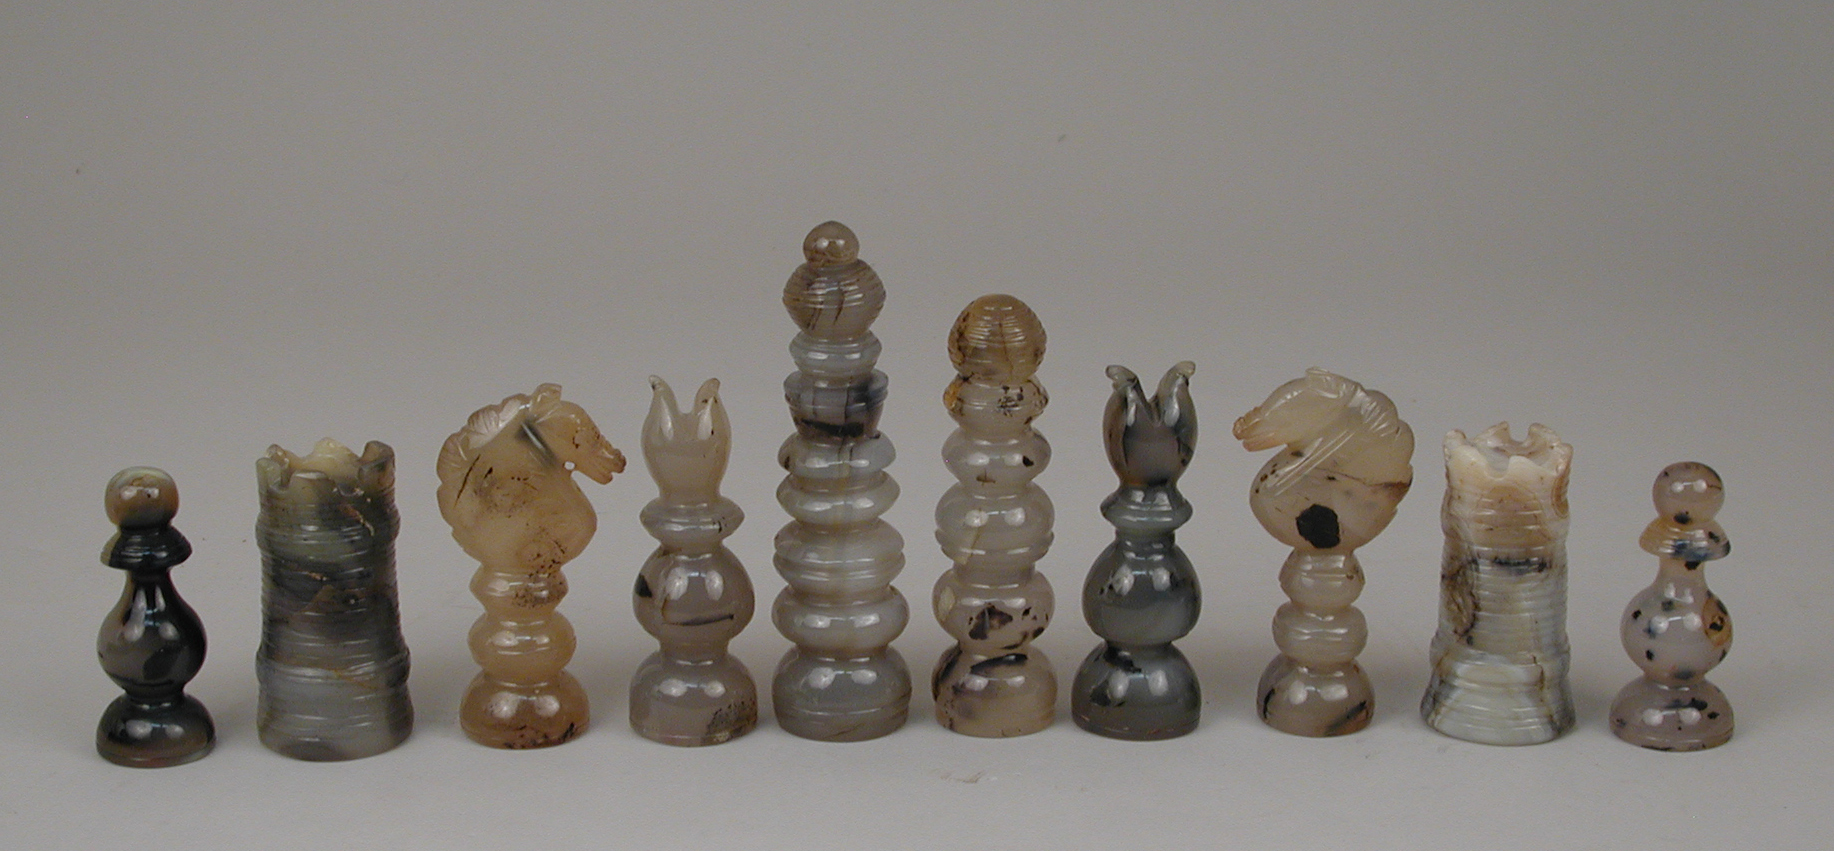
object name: chessman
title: Chessmen (32)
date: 1801-1833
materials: stone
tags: chess,games